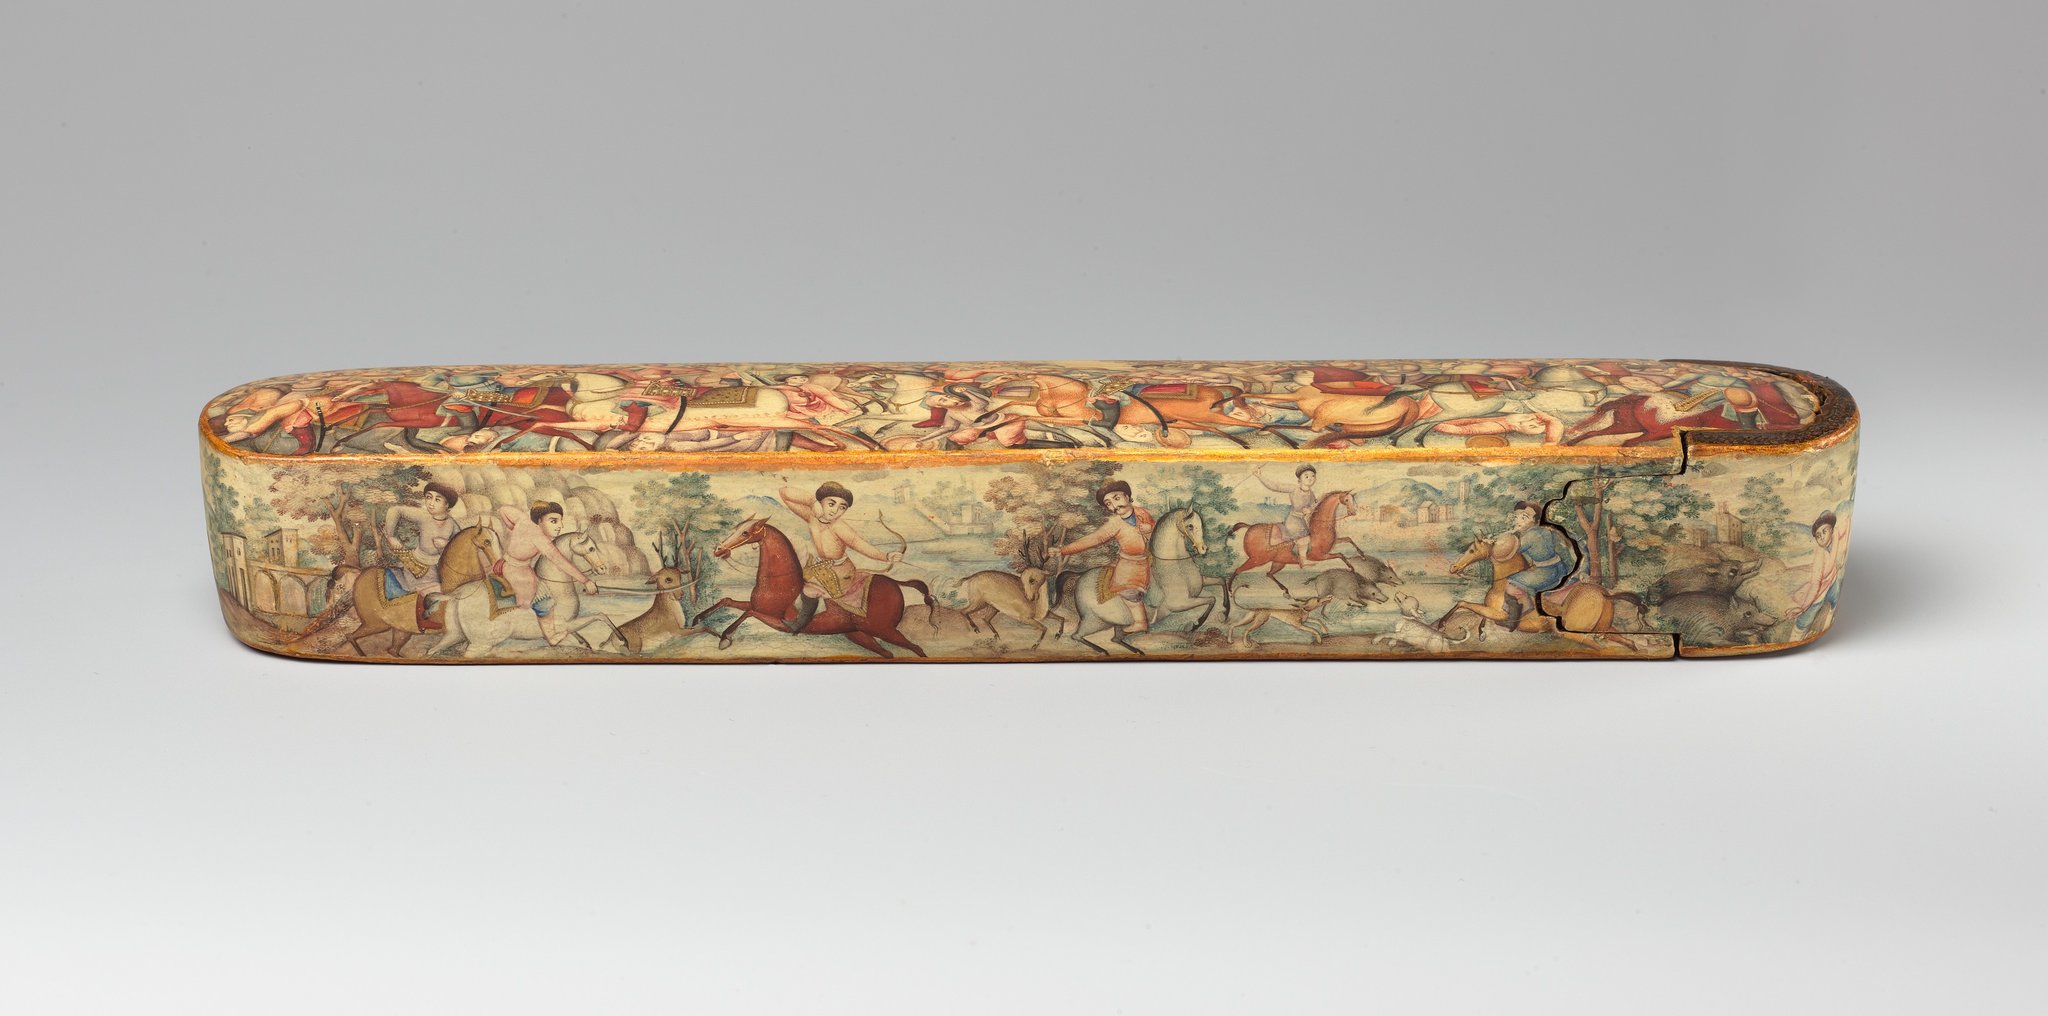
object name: pen box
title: Pen Box (Qalamdan) Depicting Shah Isma'il in a Battle against the Uzbeks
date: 1801-1833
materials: paper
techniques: lacquer, painting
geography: iran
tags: battles,men,horses